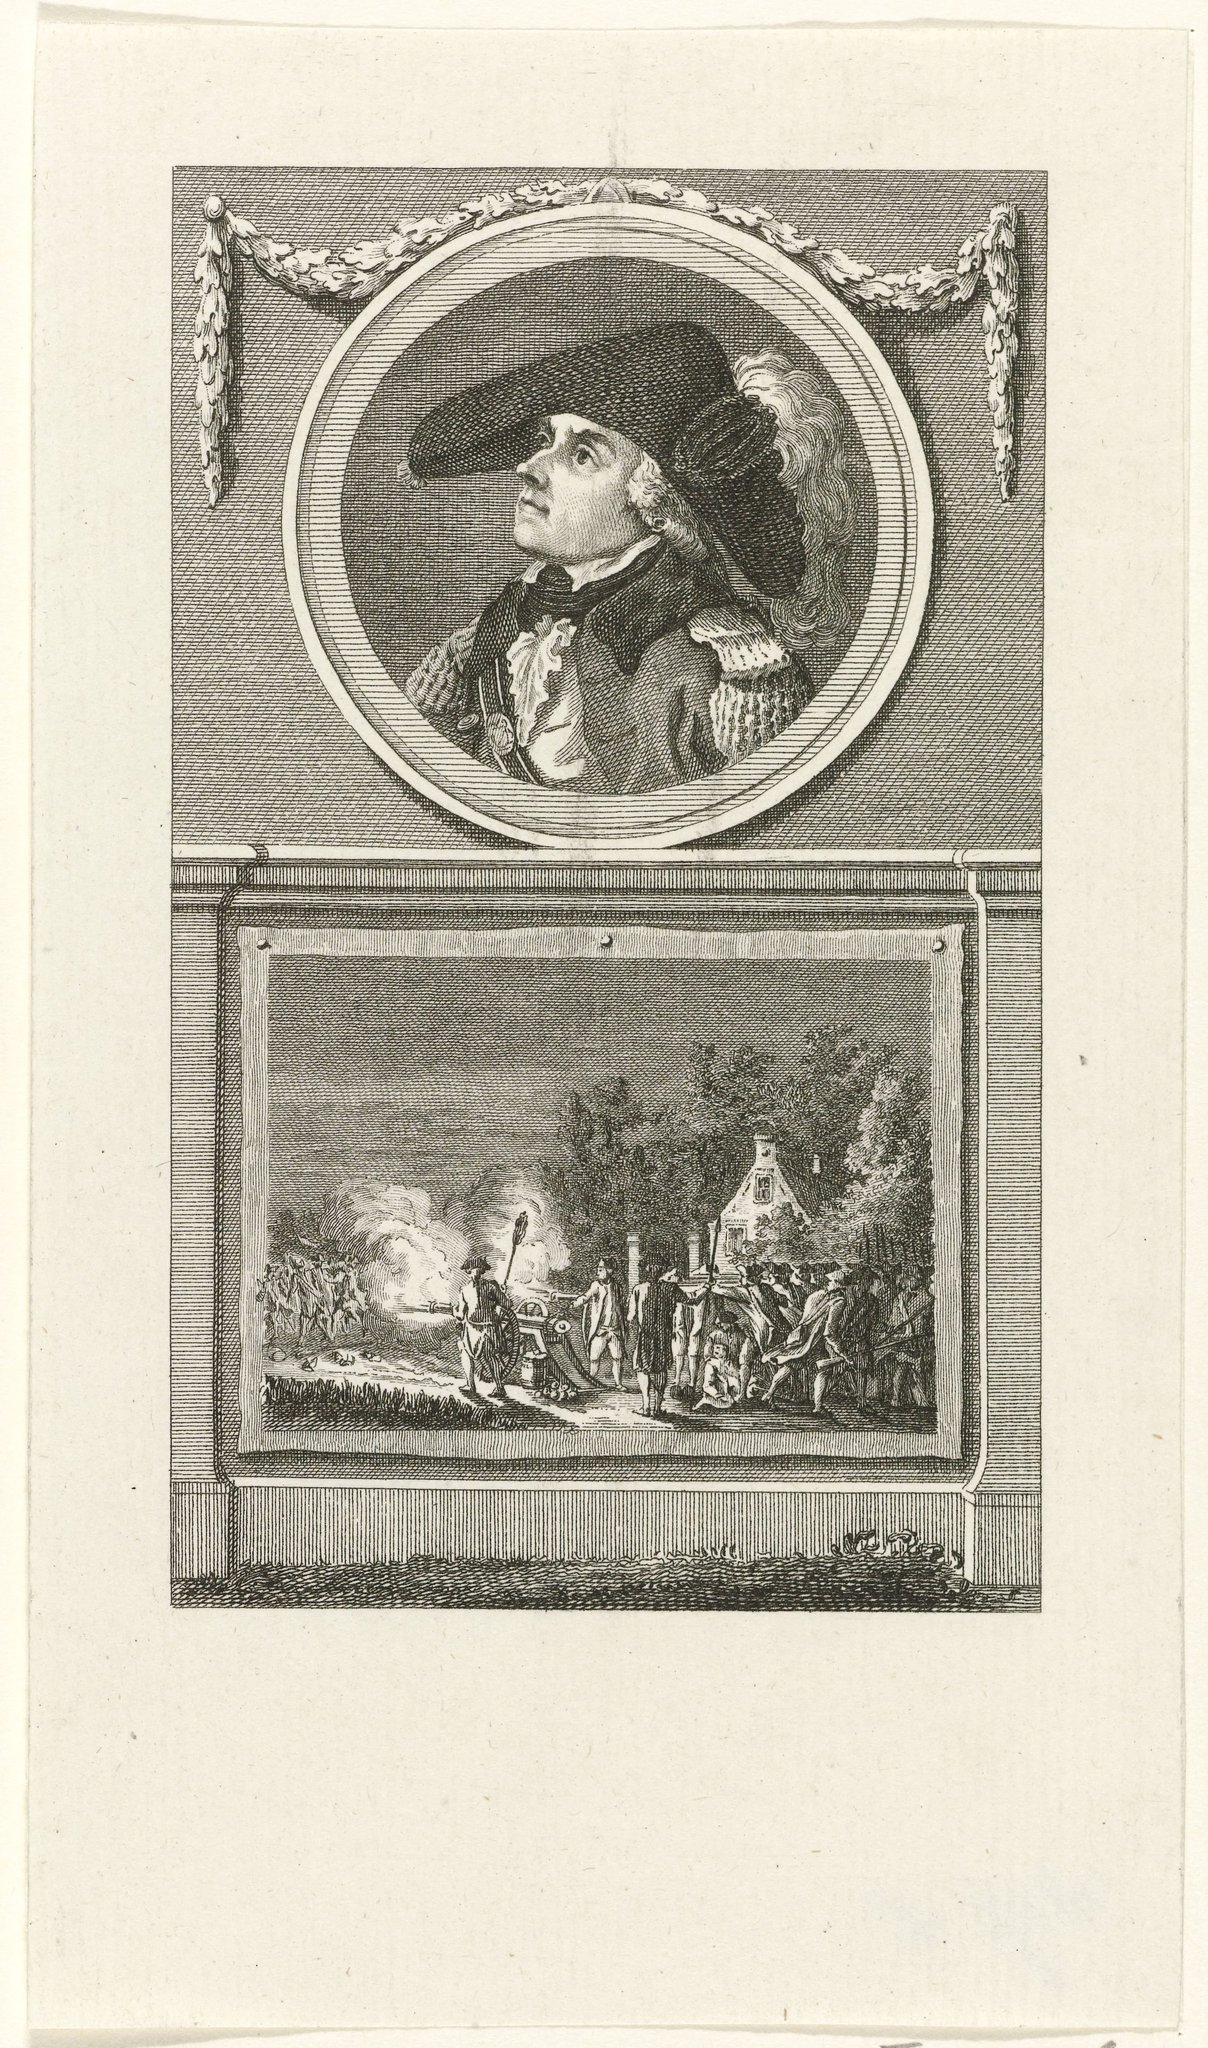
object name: print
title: Portret van Cornelis Govert Visscher en het vuurgevecht bij Vreeswijk, 1787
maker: Anonymous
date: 1787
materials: paper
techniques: engraving, etching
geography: northern netherlands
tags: battle (+ citizen soldiery, civil guard, citizen militia)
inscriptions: collector's mark: Lugt 2228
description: Blad met bovenaan een medaillon met het portret van Cornelis Govert Visscher, borstbeeld naar links, boven een afbeelding van het vuurgevecht waarin hij sneuvelde. Gevecht aan de vaart bij Vreeswijk buiten Utrecht tussen gewapende burgers van de Utrechtse schutterij en troepen van het regiment Van Efferen, in de avond van 9 mei 1787.